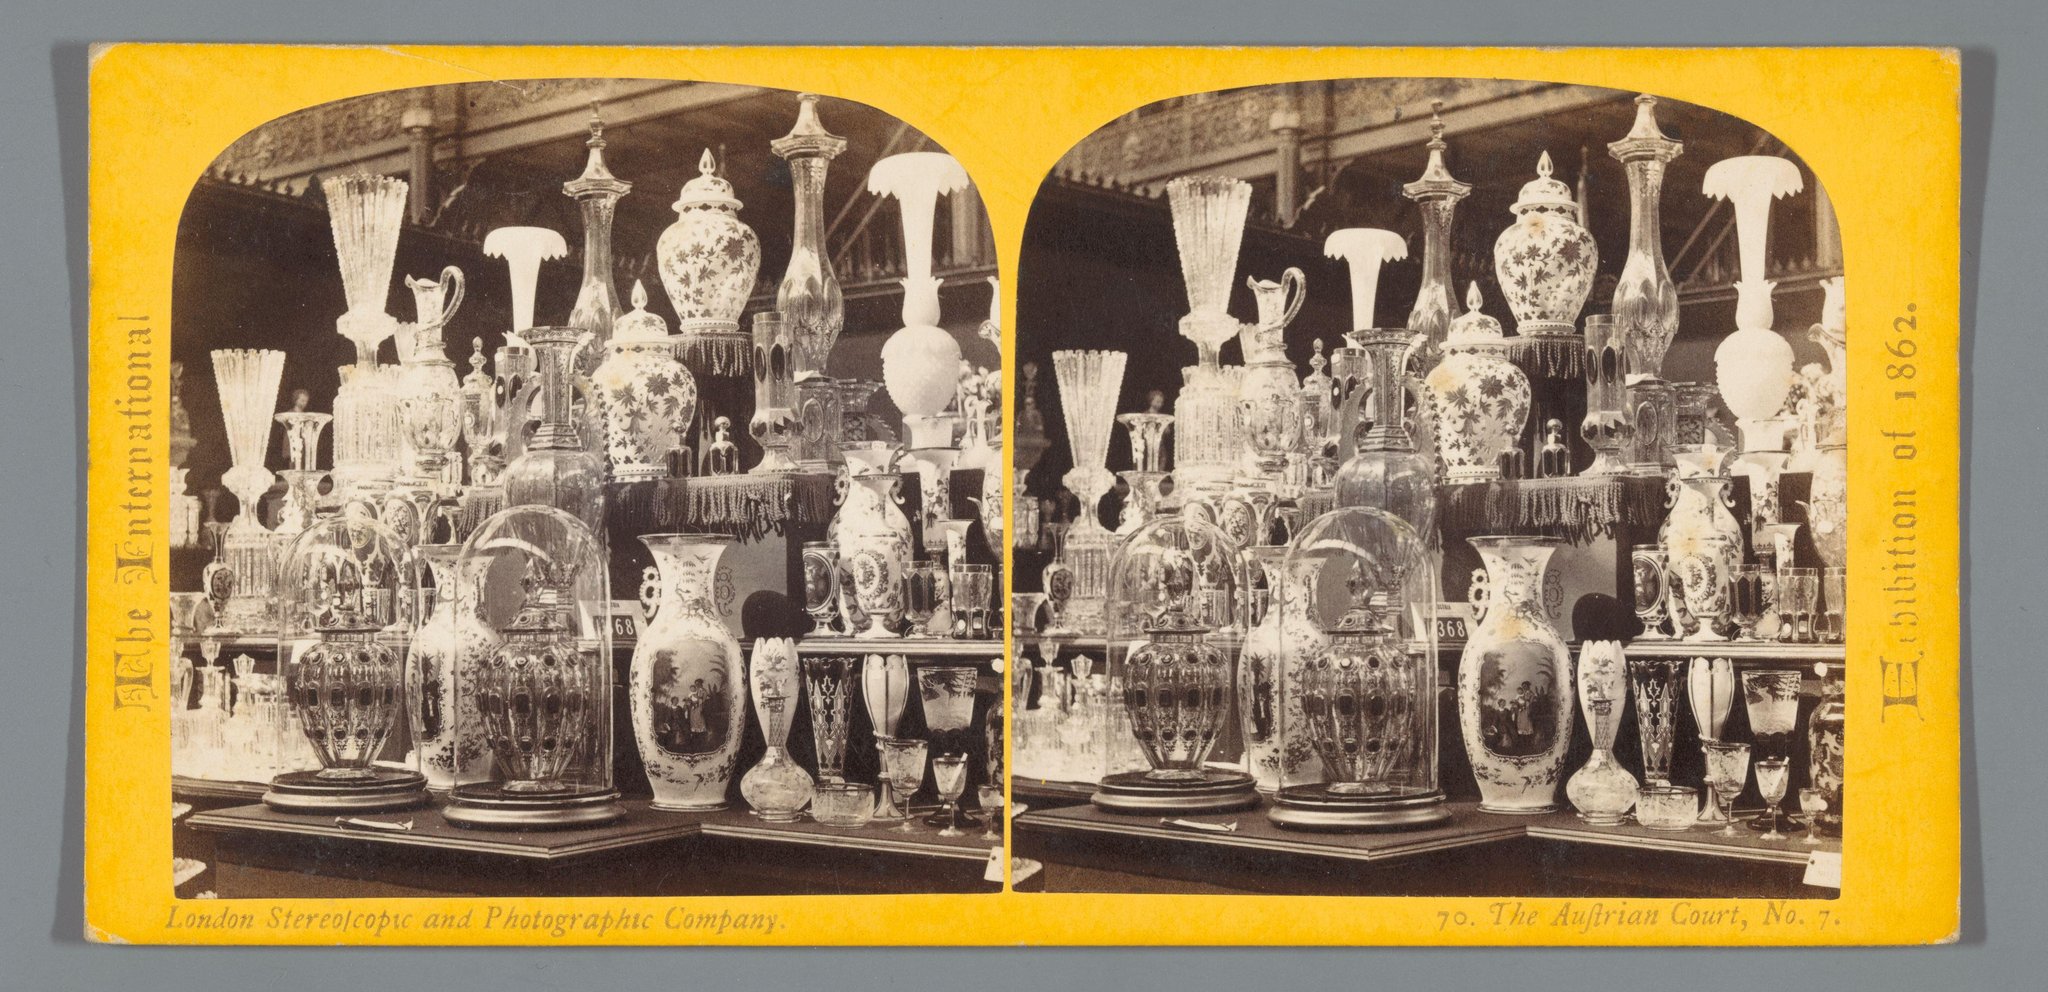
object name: stereograph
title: Oostenrijkse afdeling tijdens de Wereldtentoonstelling van 1862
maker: william england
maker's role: fotograaf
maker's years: 1816-1896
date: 1862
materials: cardboard, paper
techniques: albumen print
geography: london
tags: world fair, world exhibition, london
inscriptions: number: ‘70.’, inscription: ‘L’